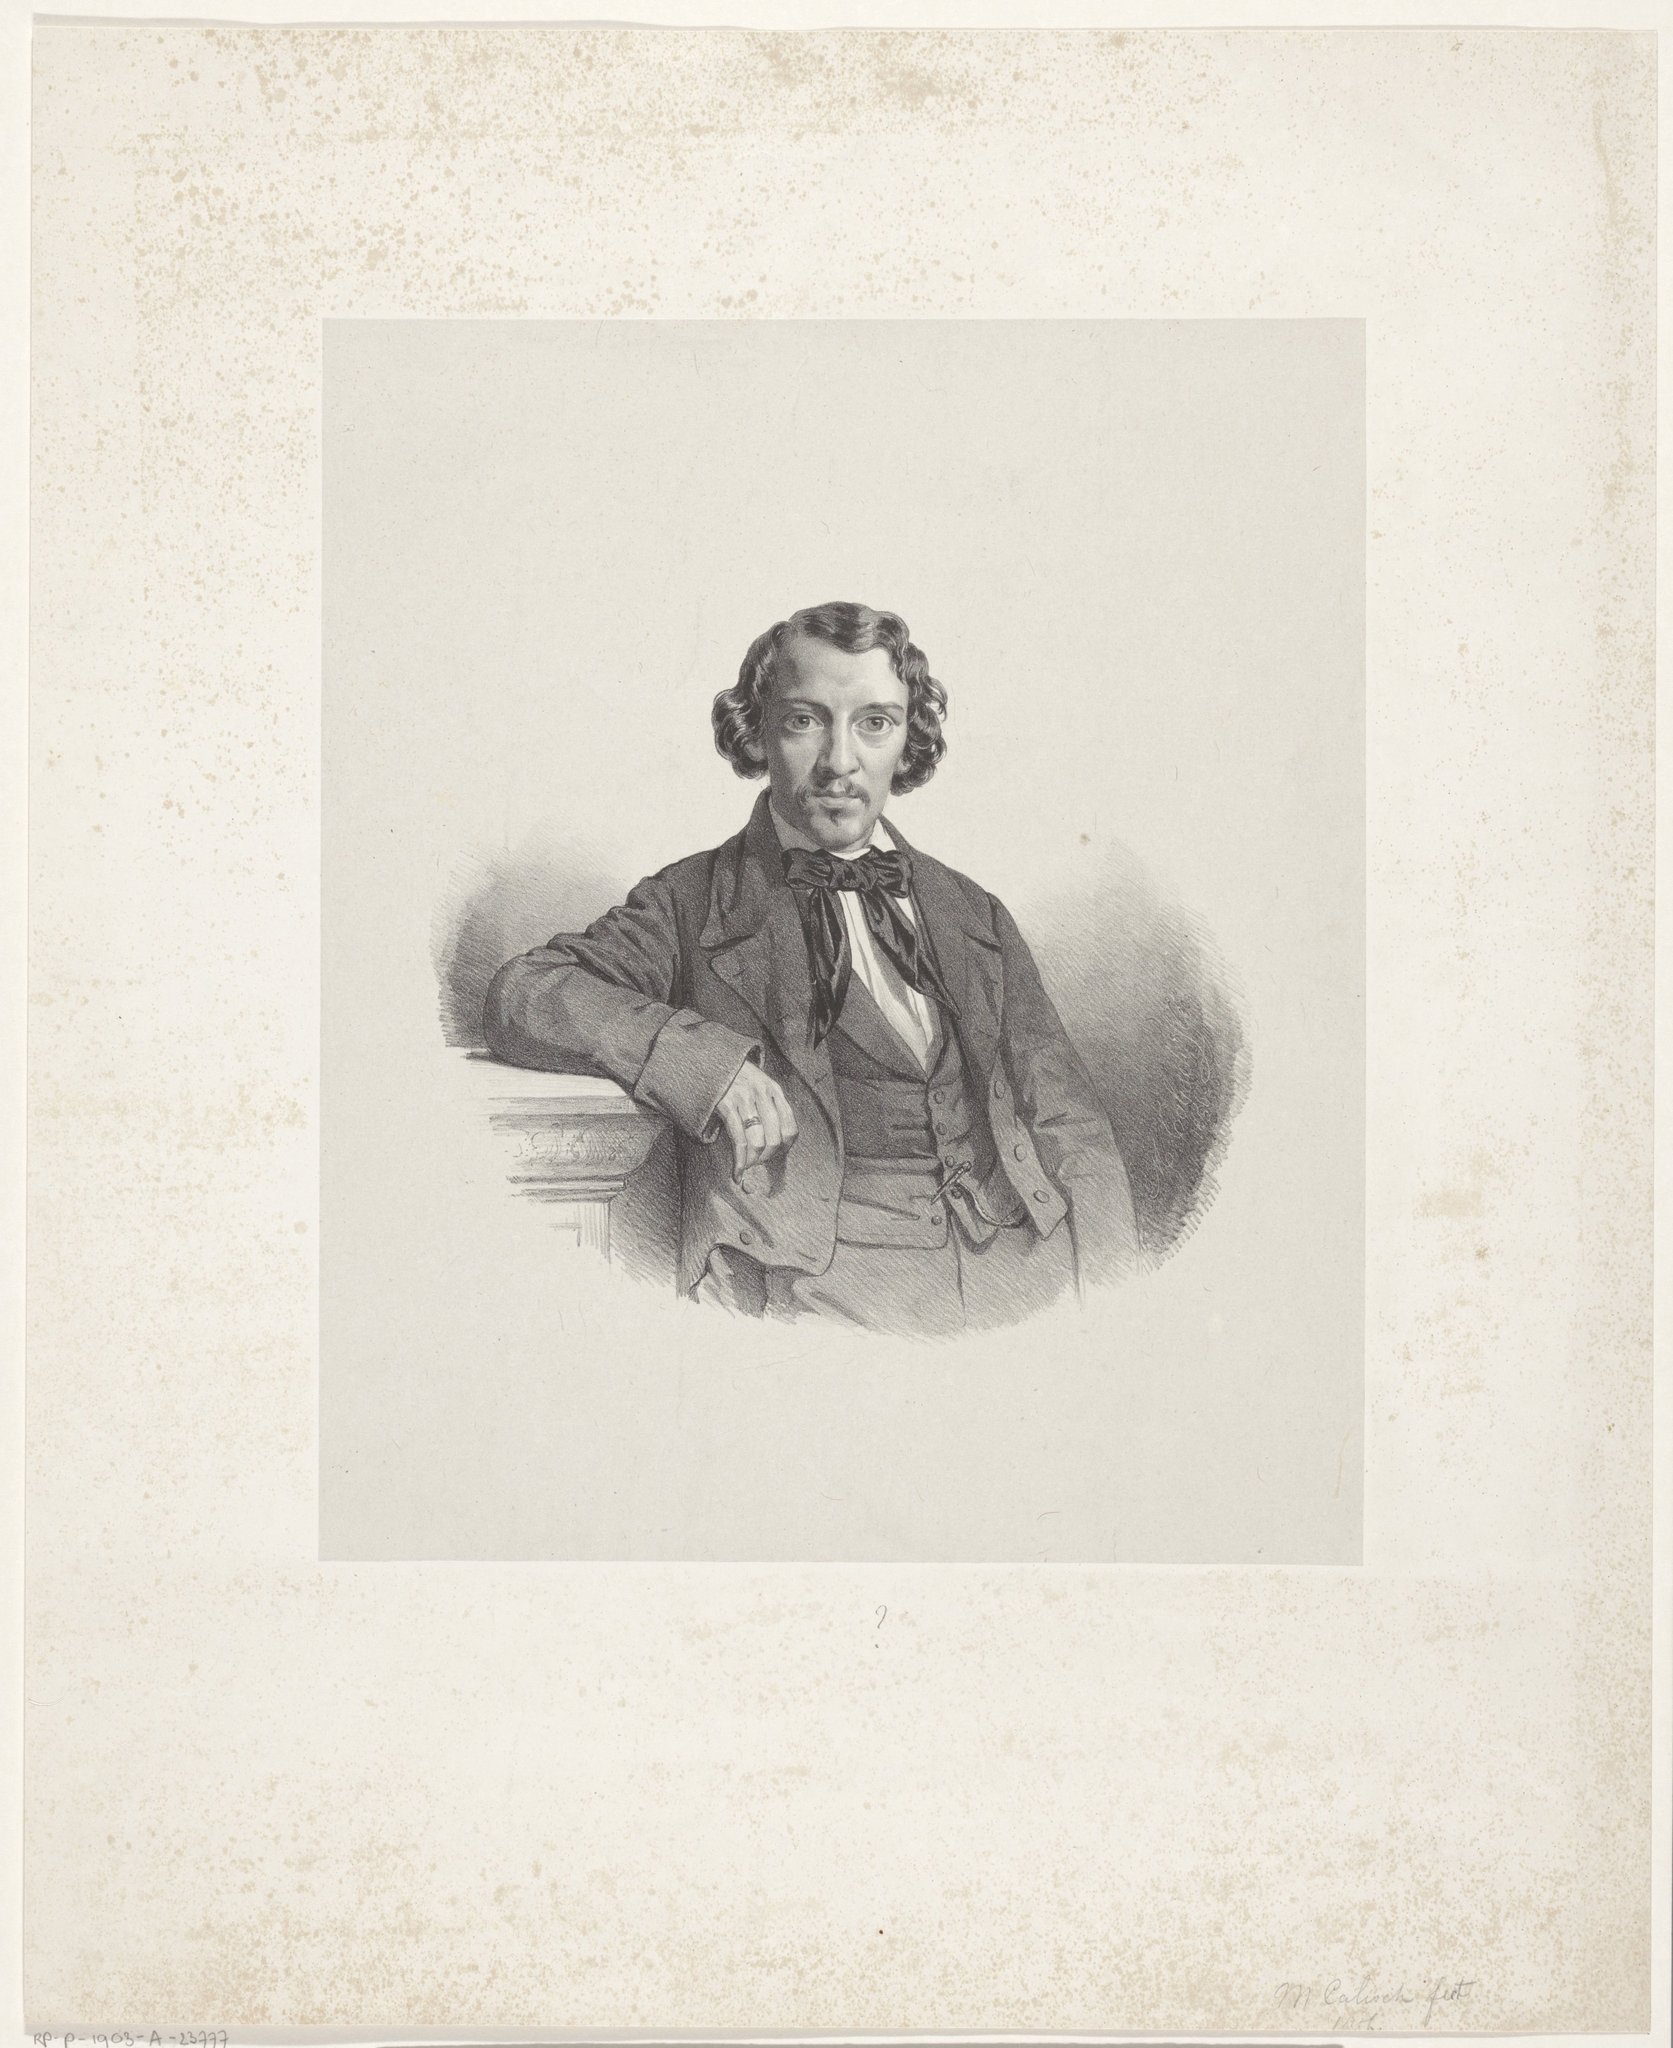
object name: print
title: Portret van een onbekende man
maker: moritz calisch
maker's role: draughtsman, print maker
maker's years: 1819-1870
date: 1850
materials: paper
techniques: lithograph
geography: amsterdam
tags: standing figure, historical persons (+ half-length portrait), cupboard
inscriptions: collector's mark: Lugt 2228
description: De man staat en leunt met zijn linkerarm op de bovenkant van een kast met een gedecoreerde bovenrand.